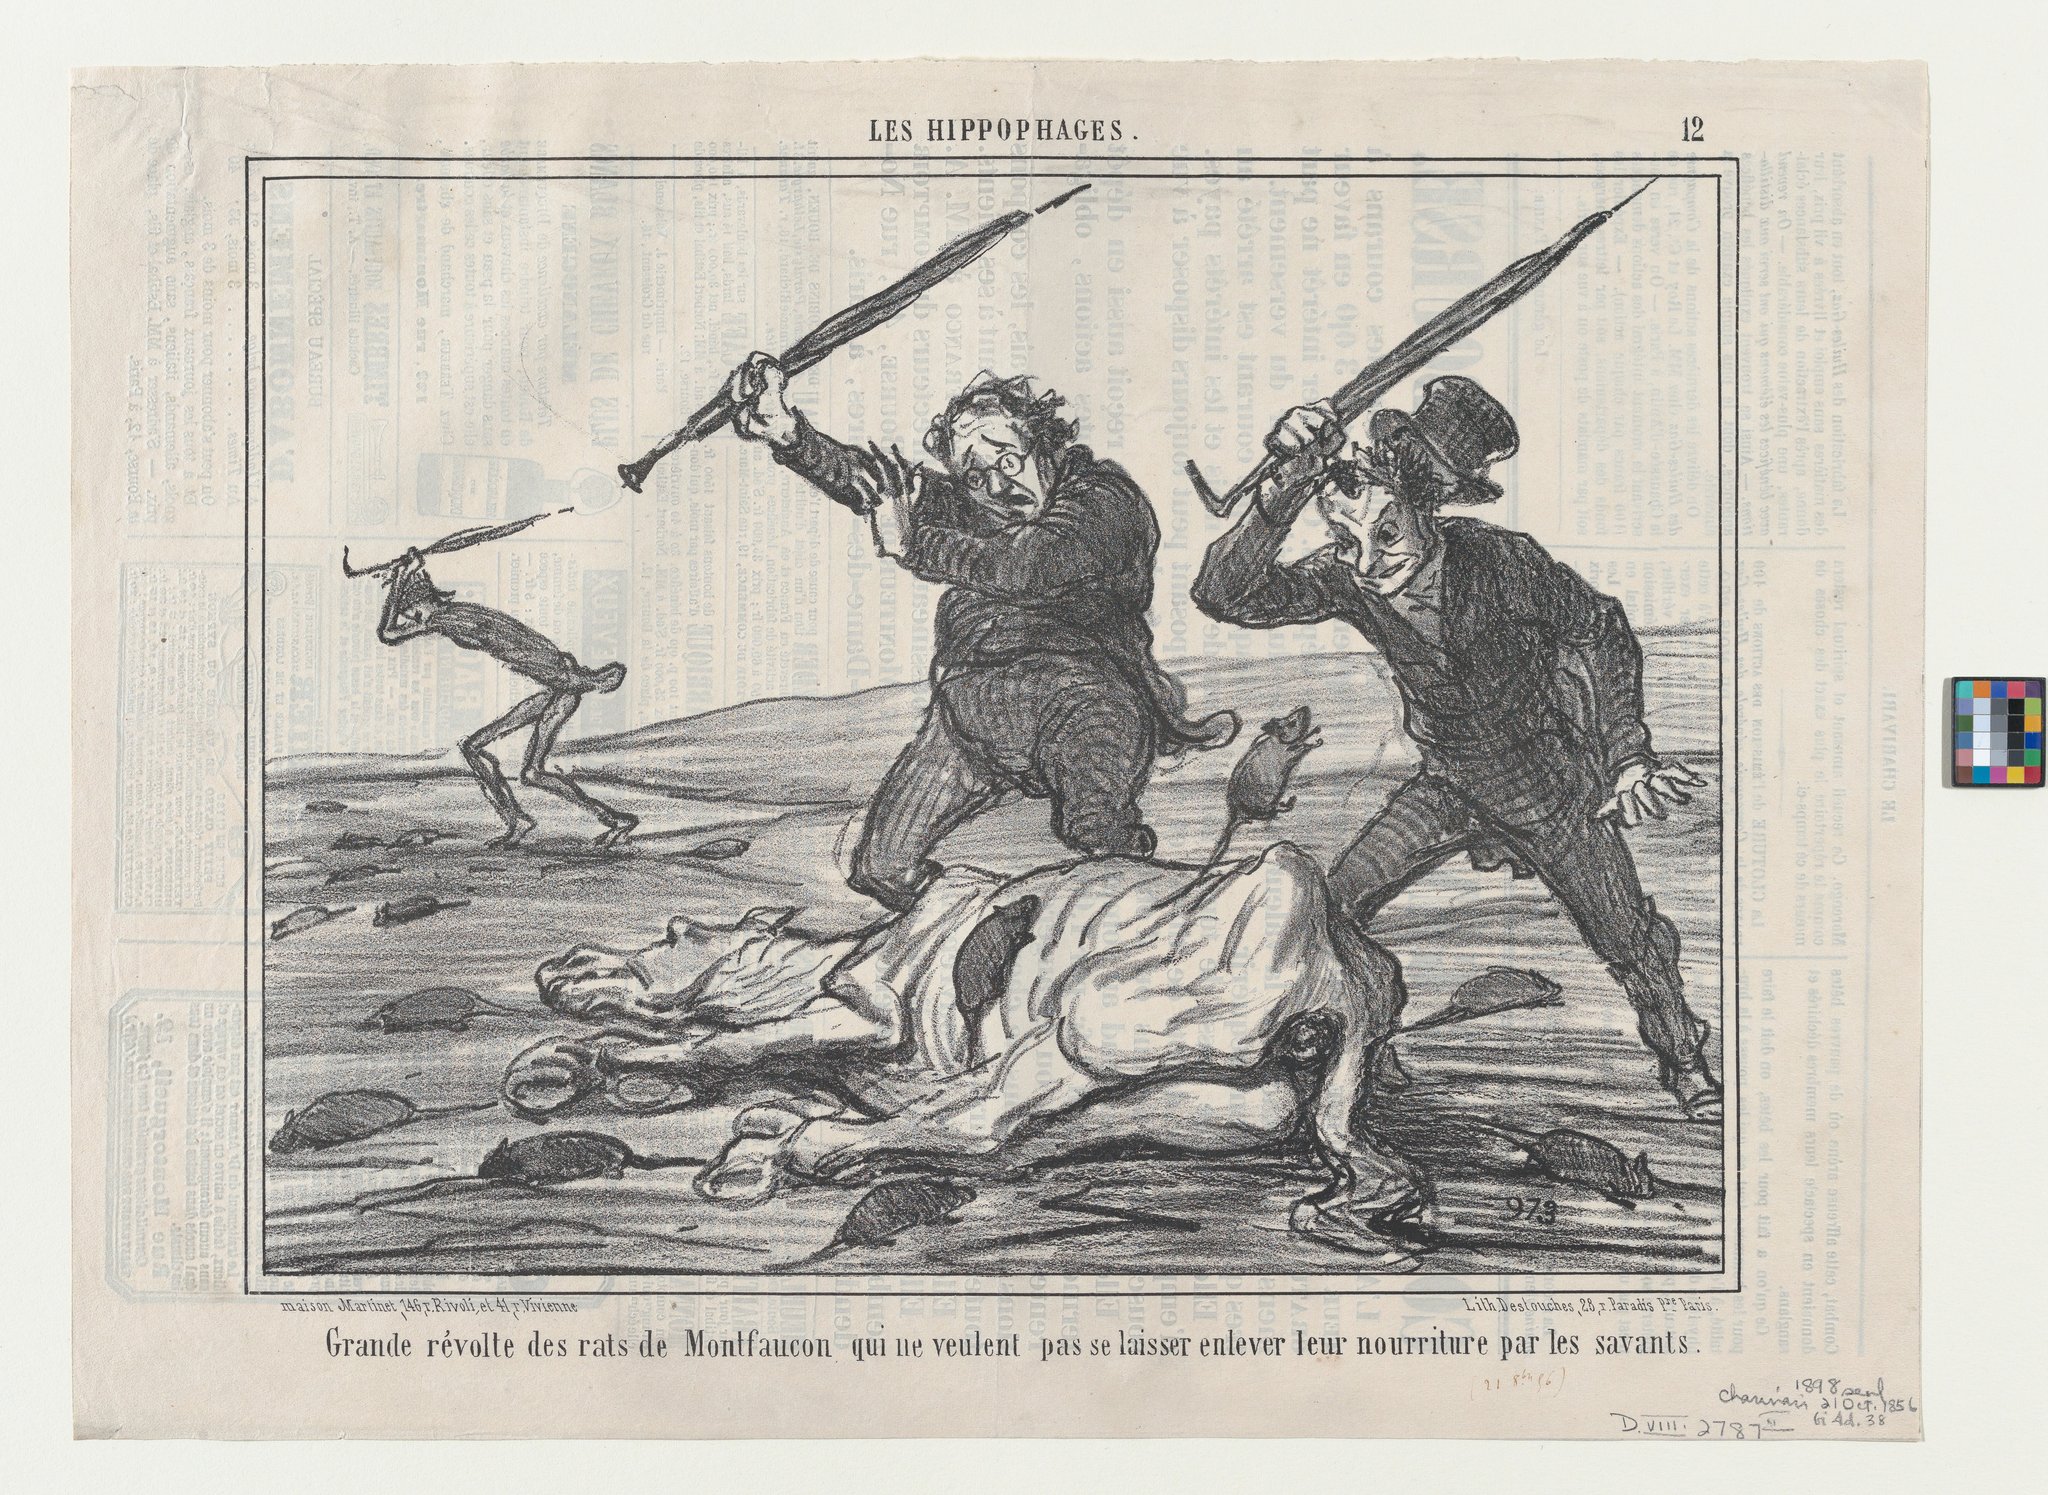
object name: print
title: Grande révolte des rats de montfaucon, from Les Hippophages, published in Le Charivari, October 21, 1856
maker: honoré daumier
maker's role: artist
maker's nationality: french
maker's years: 1808-1879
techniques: lithograph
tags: men,horses,mice